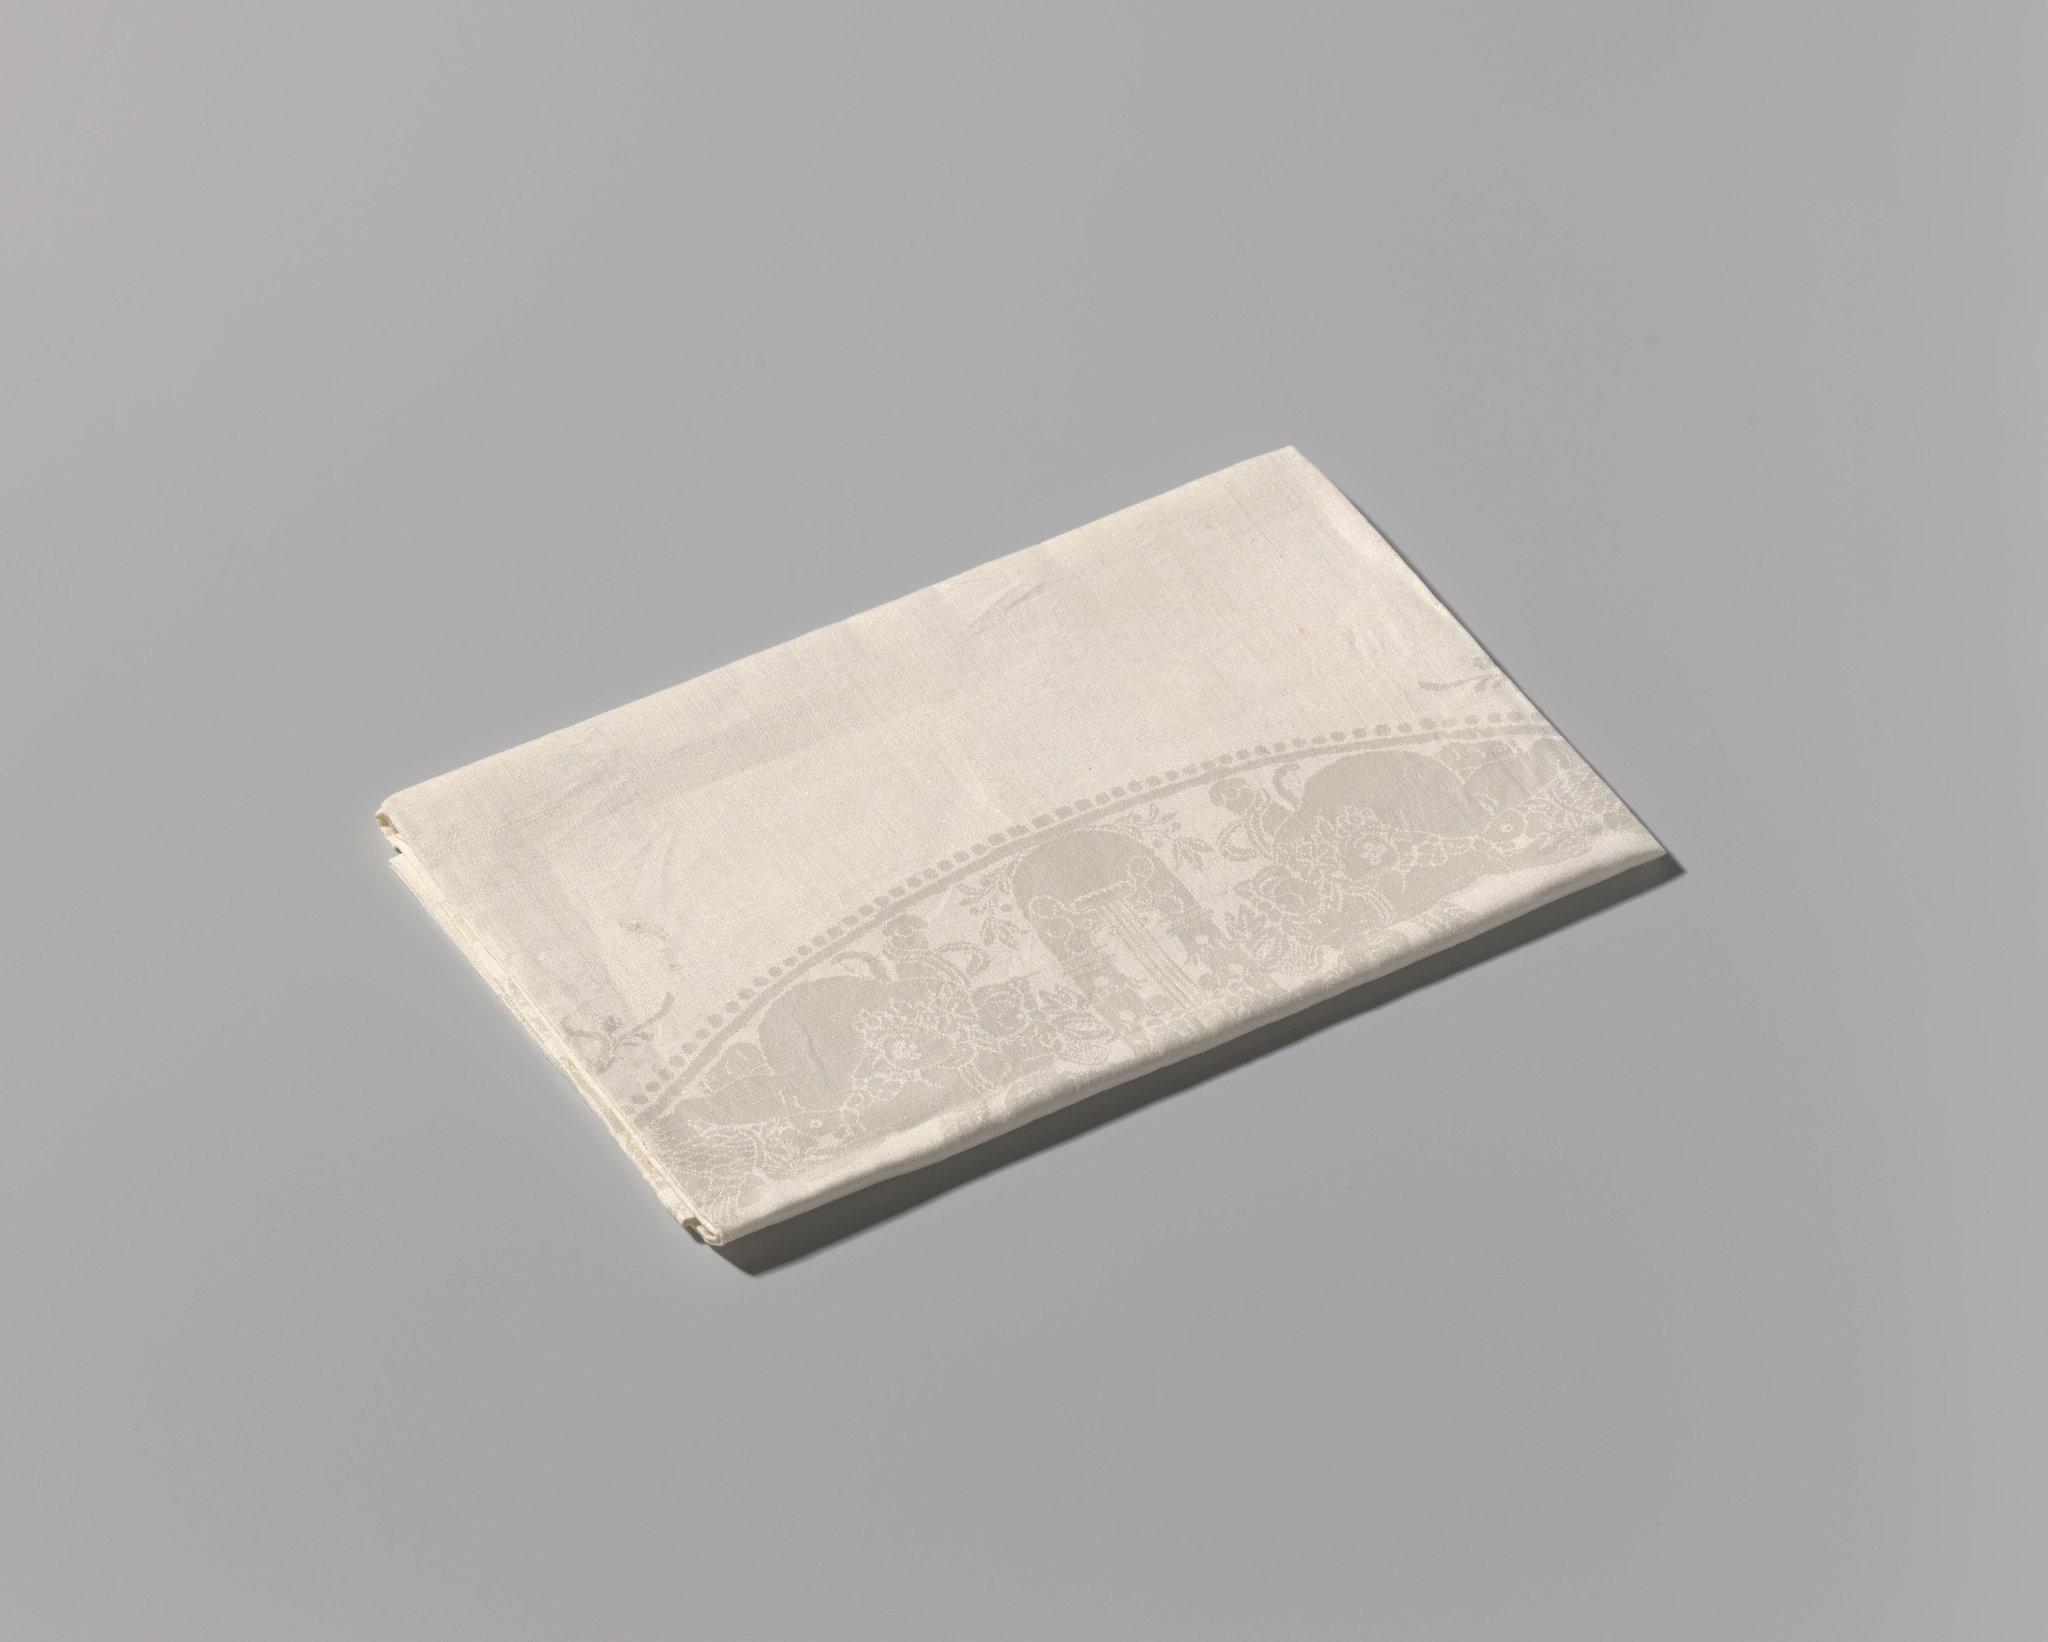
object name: napkin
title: Servet met amortjes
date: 1850-1899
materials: linen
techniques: damask